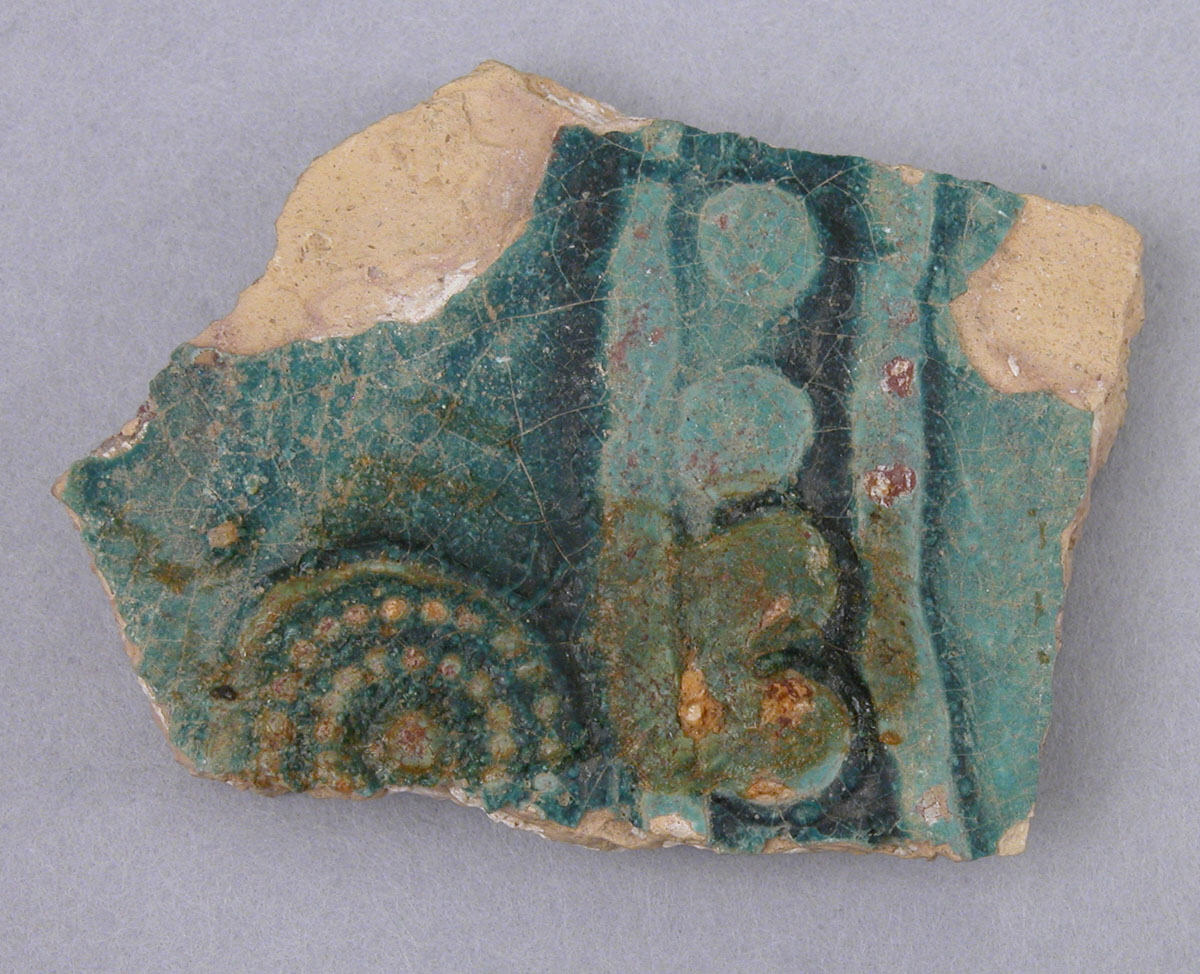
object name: fragment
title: Ceramic Fragment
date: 801-1000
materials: earthenware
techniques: glazing, molding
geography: saudi arabia